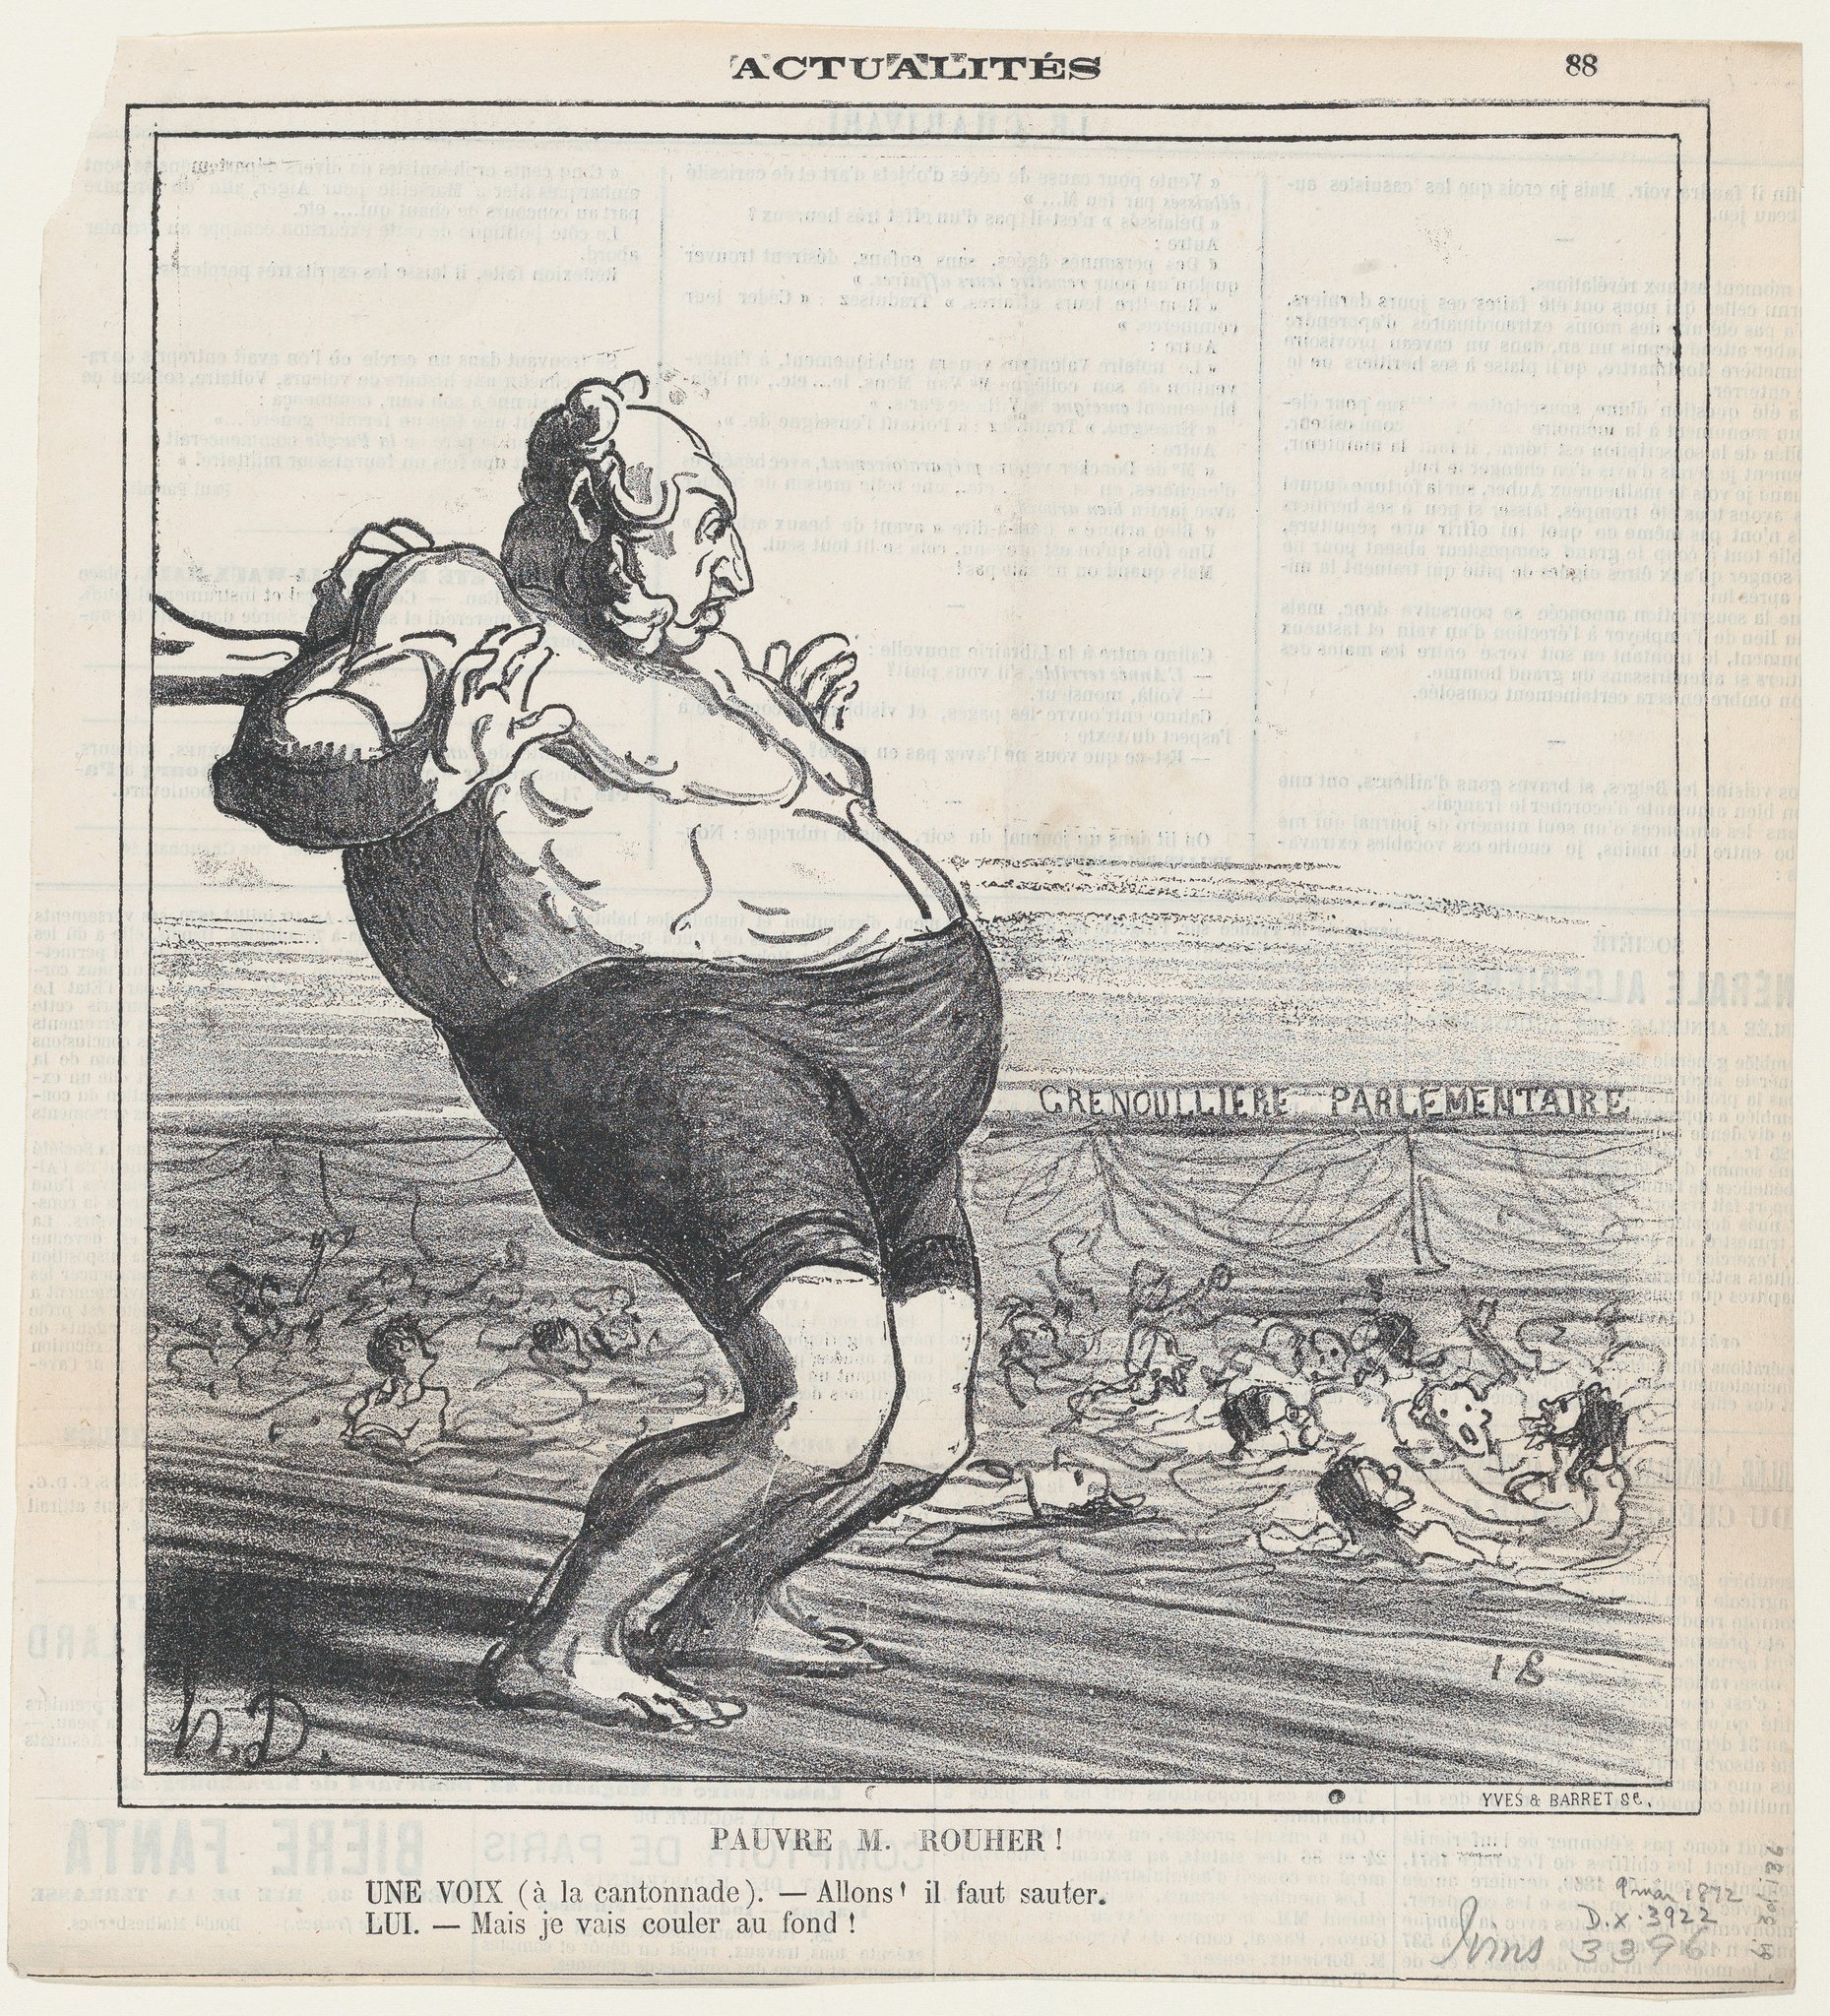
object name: print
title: Poor Mr. Rouher! A voice (in the wings): –Go ahead! Jump! He: –But I'll sink to the bottom!, from 'News of the day,' published in Le Charivari, May 9, 1872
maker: honoré daumier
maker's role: artist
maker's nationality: french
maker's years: 1808-1879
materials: paper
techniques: lithograph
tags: satire,men,swimming